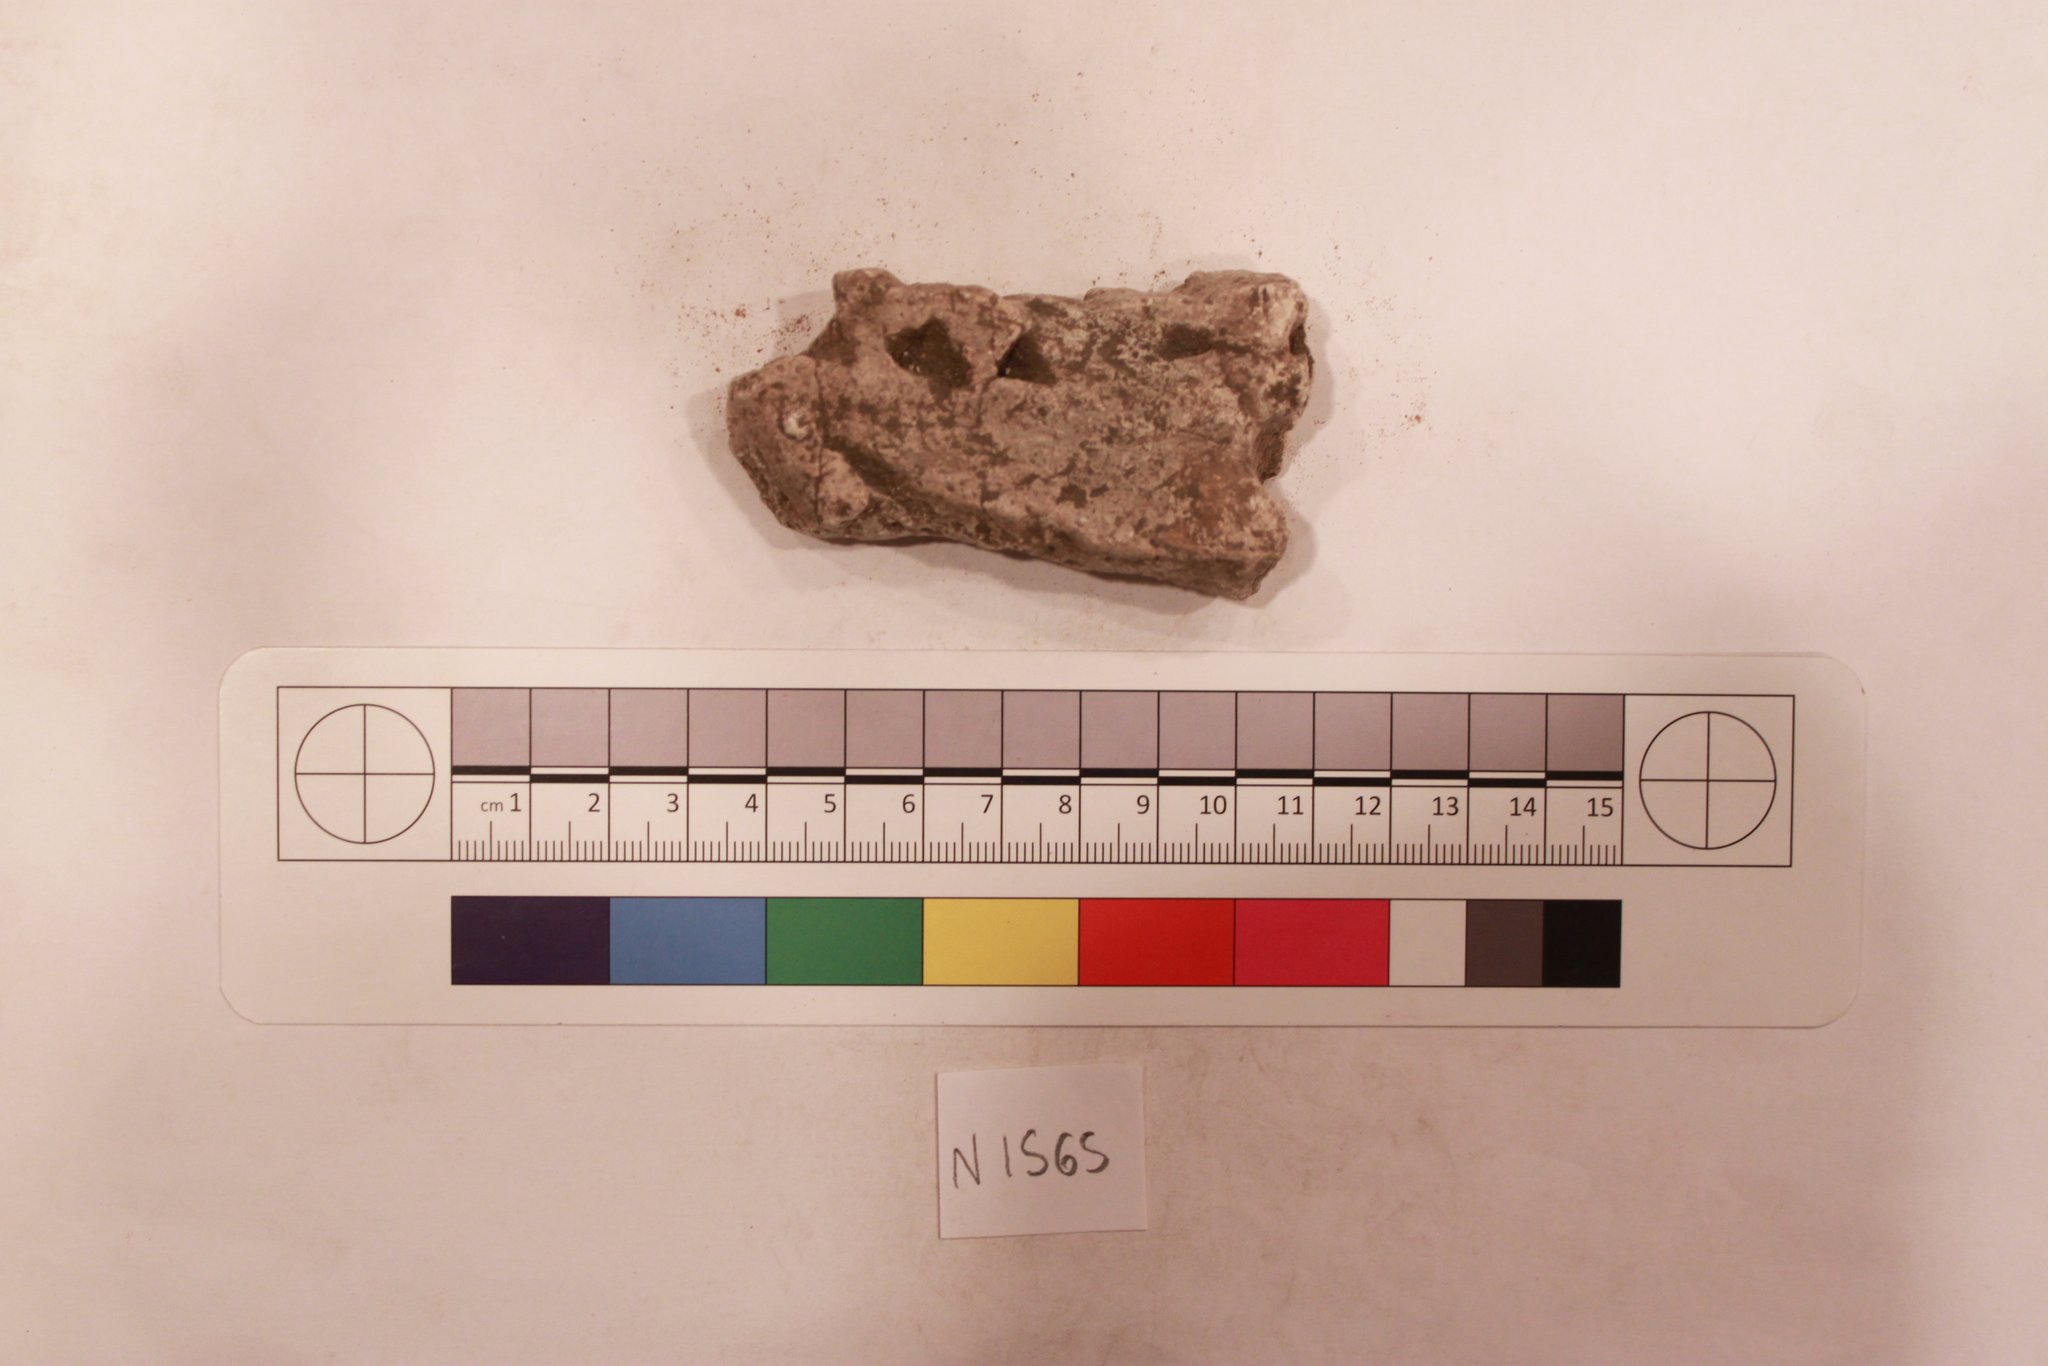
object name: fragment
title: Stucco Fragment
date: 701-1200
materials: plaster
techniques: carving, painting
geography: iran